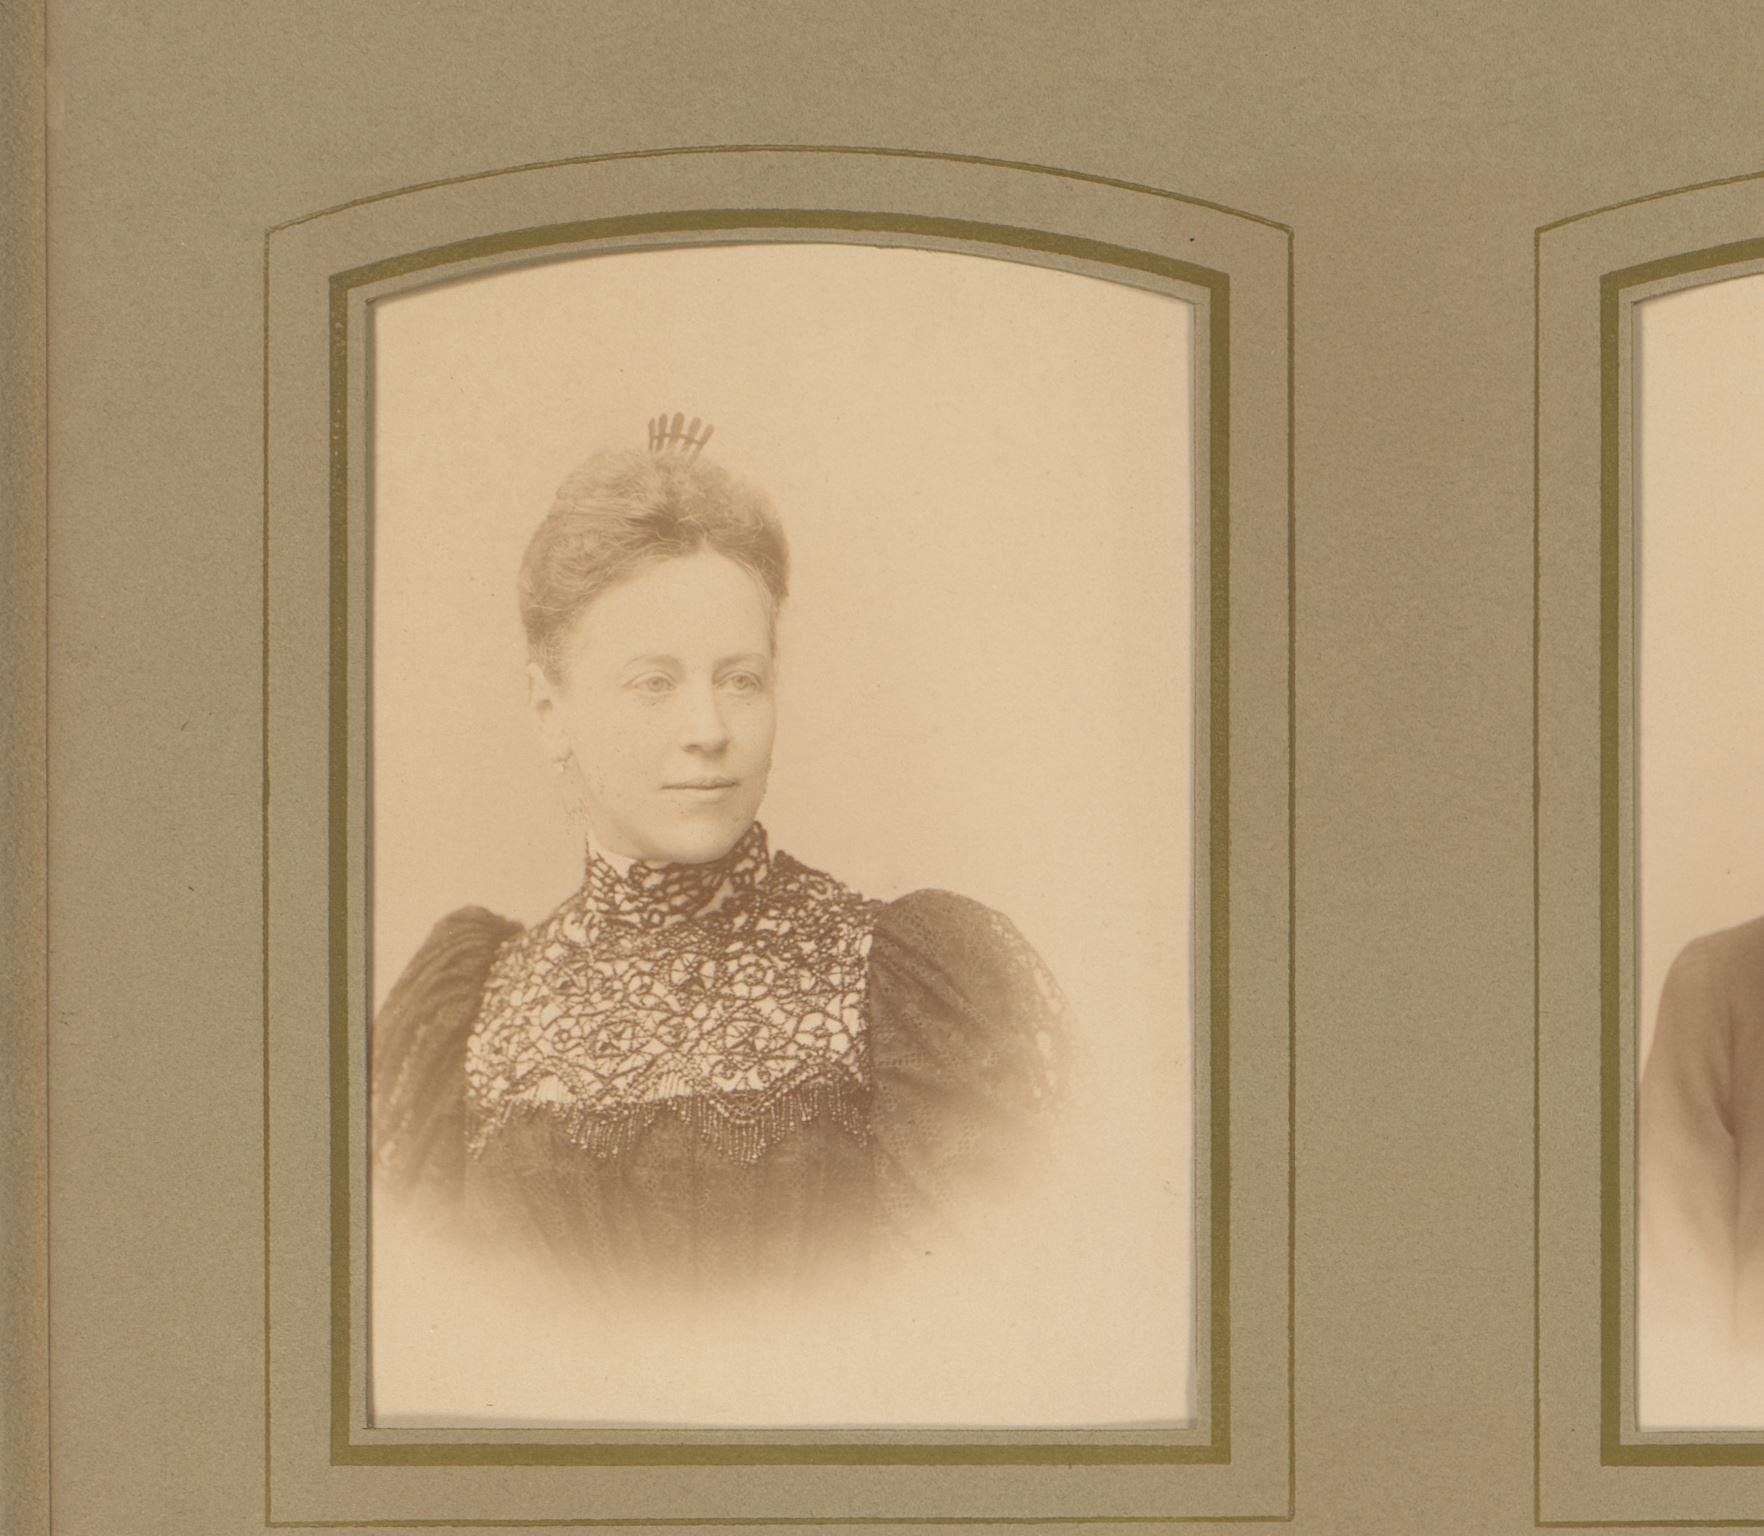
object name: photograph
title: Portret van een vrouw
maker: emil tiedemann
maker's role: fotograaf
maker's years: 1858-1892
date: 1850-1900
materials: cardboard, photographic support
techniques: albumen print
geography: braunschweig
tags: historical persons - bb - woman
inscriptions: inscription: ‘Emil Tiedemann/ Braunschweig/ 66 Bohlweg 66./ Nachbestellungen beliebe man/ nur in Braunschweig aufzugeben.’